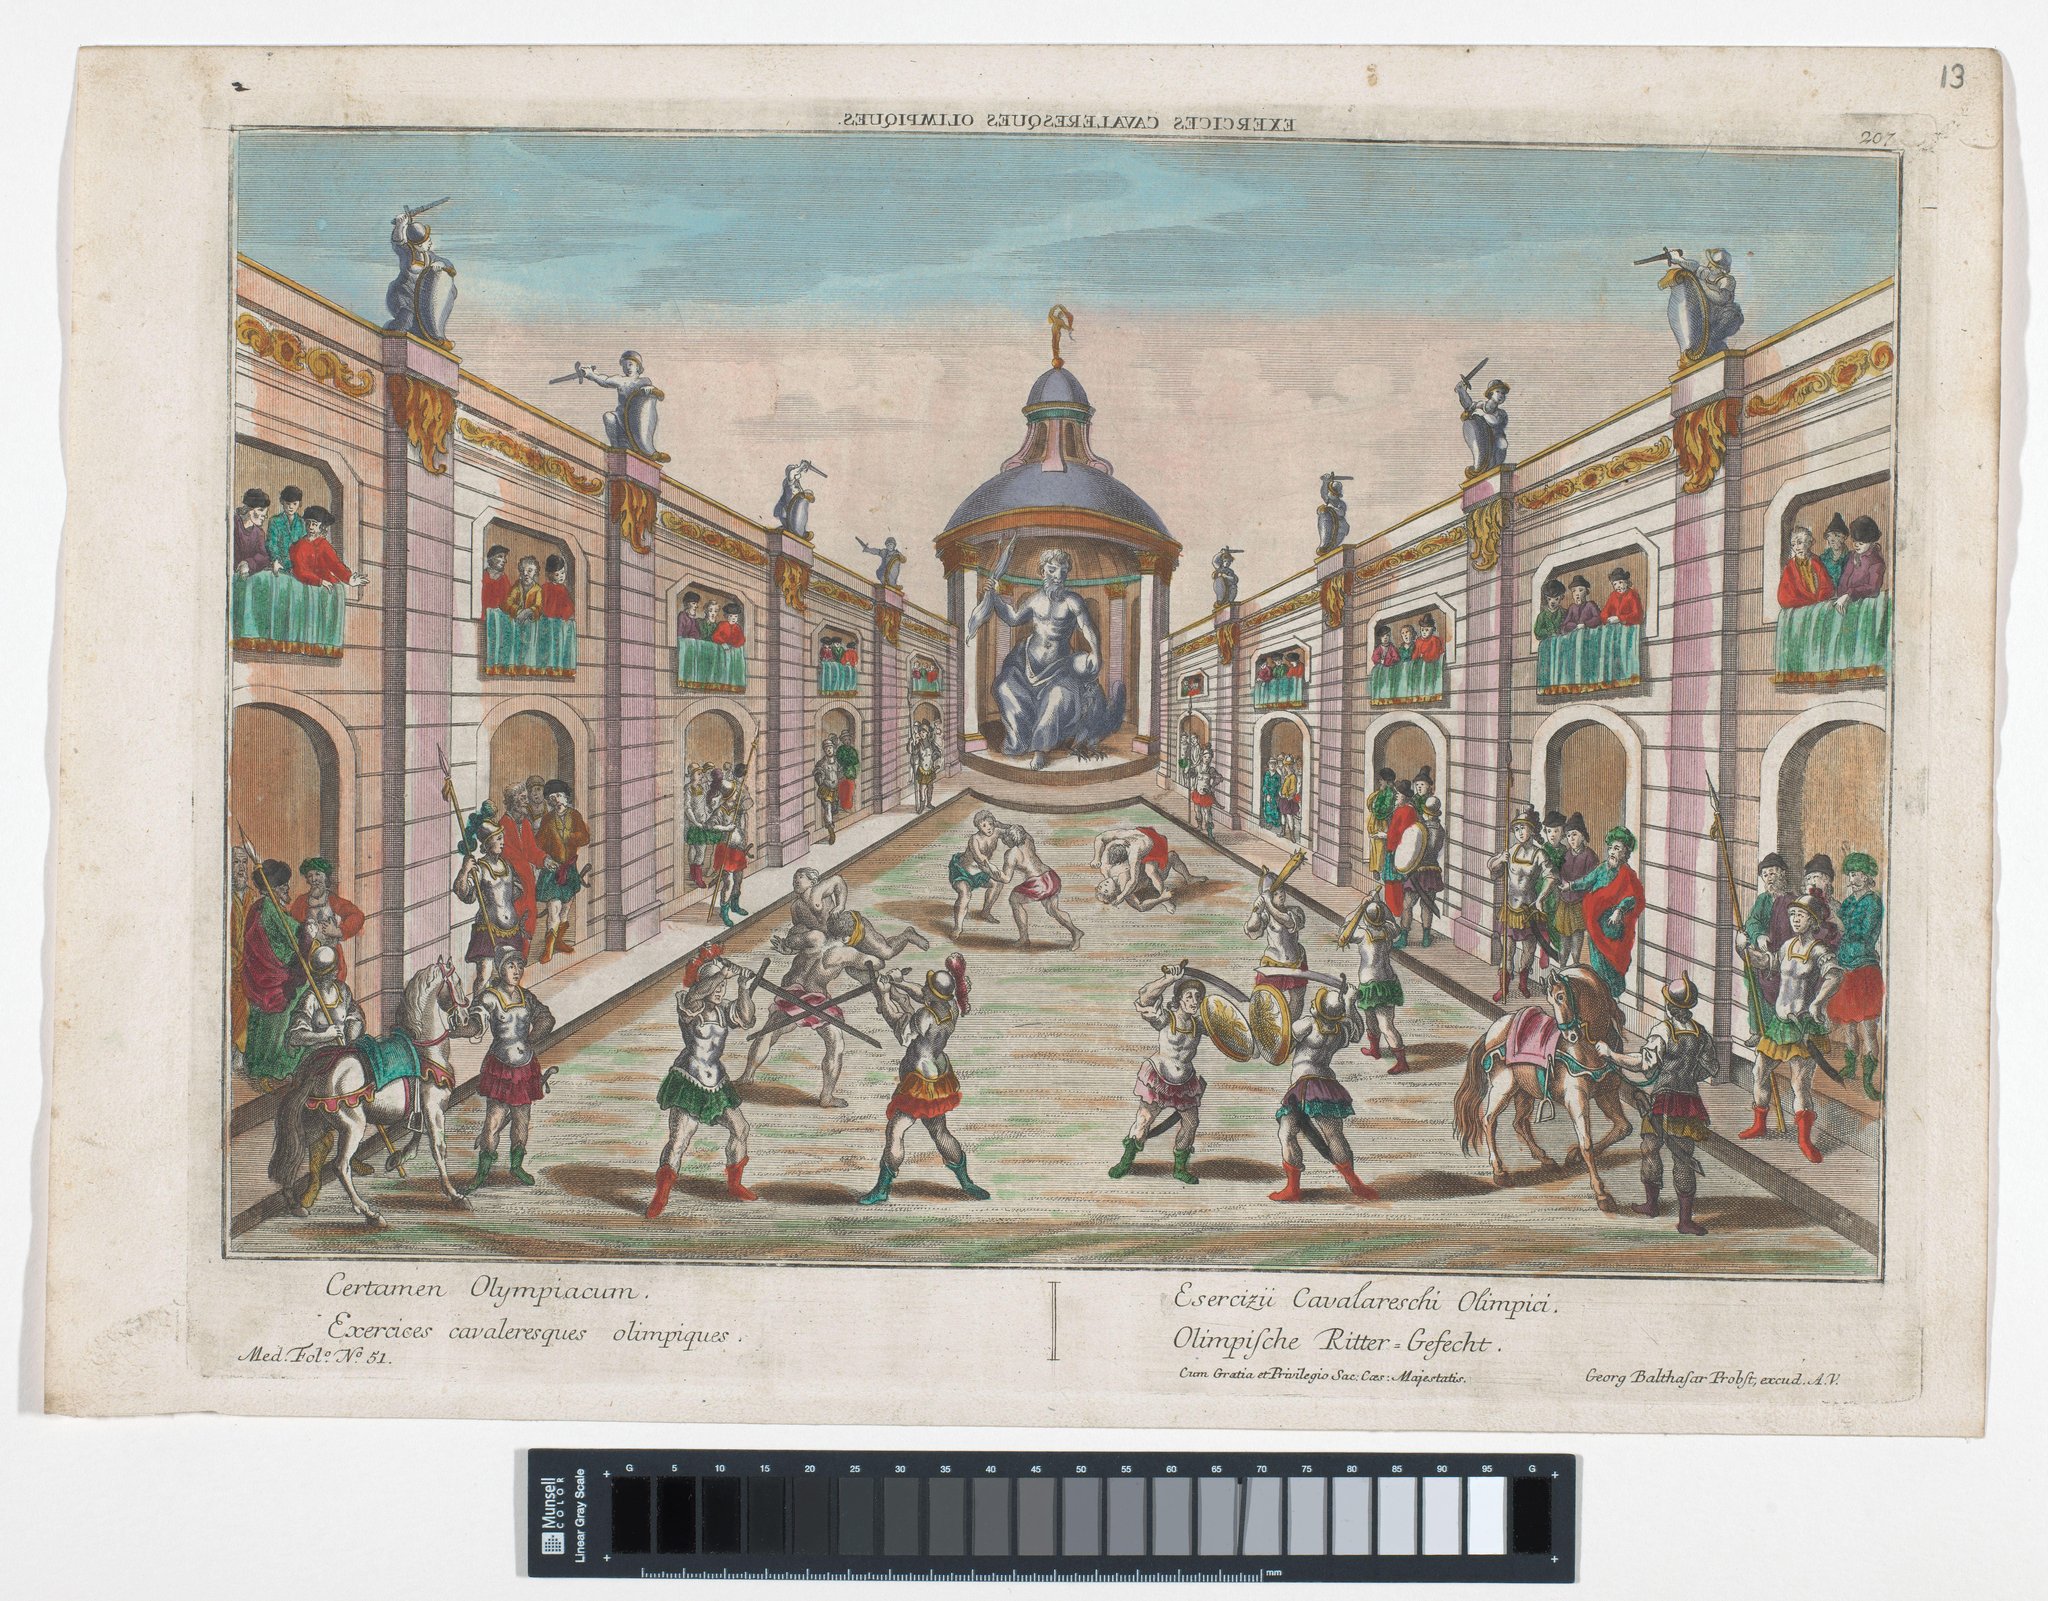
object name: print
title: Romulus en Remus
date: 1742-1801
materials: paper, watercolor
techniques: brush, etching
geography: germany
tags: (story of) romulus and remus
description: Mogelijk worden Romulus en Remus hier tot strijdvaardige mannen opgeleid. Op de achtergrond zit een man op een troon met een vogel naast zich en vuur in zijn rechterhand (Prometheus?). Rechtsboven genummerd: 207. Linksonder genummerd: 51.